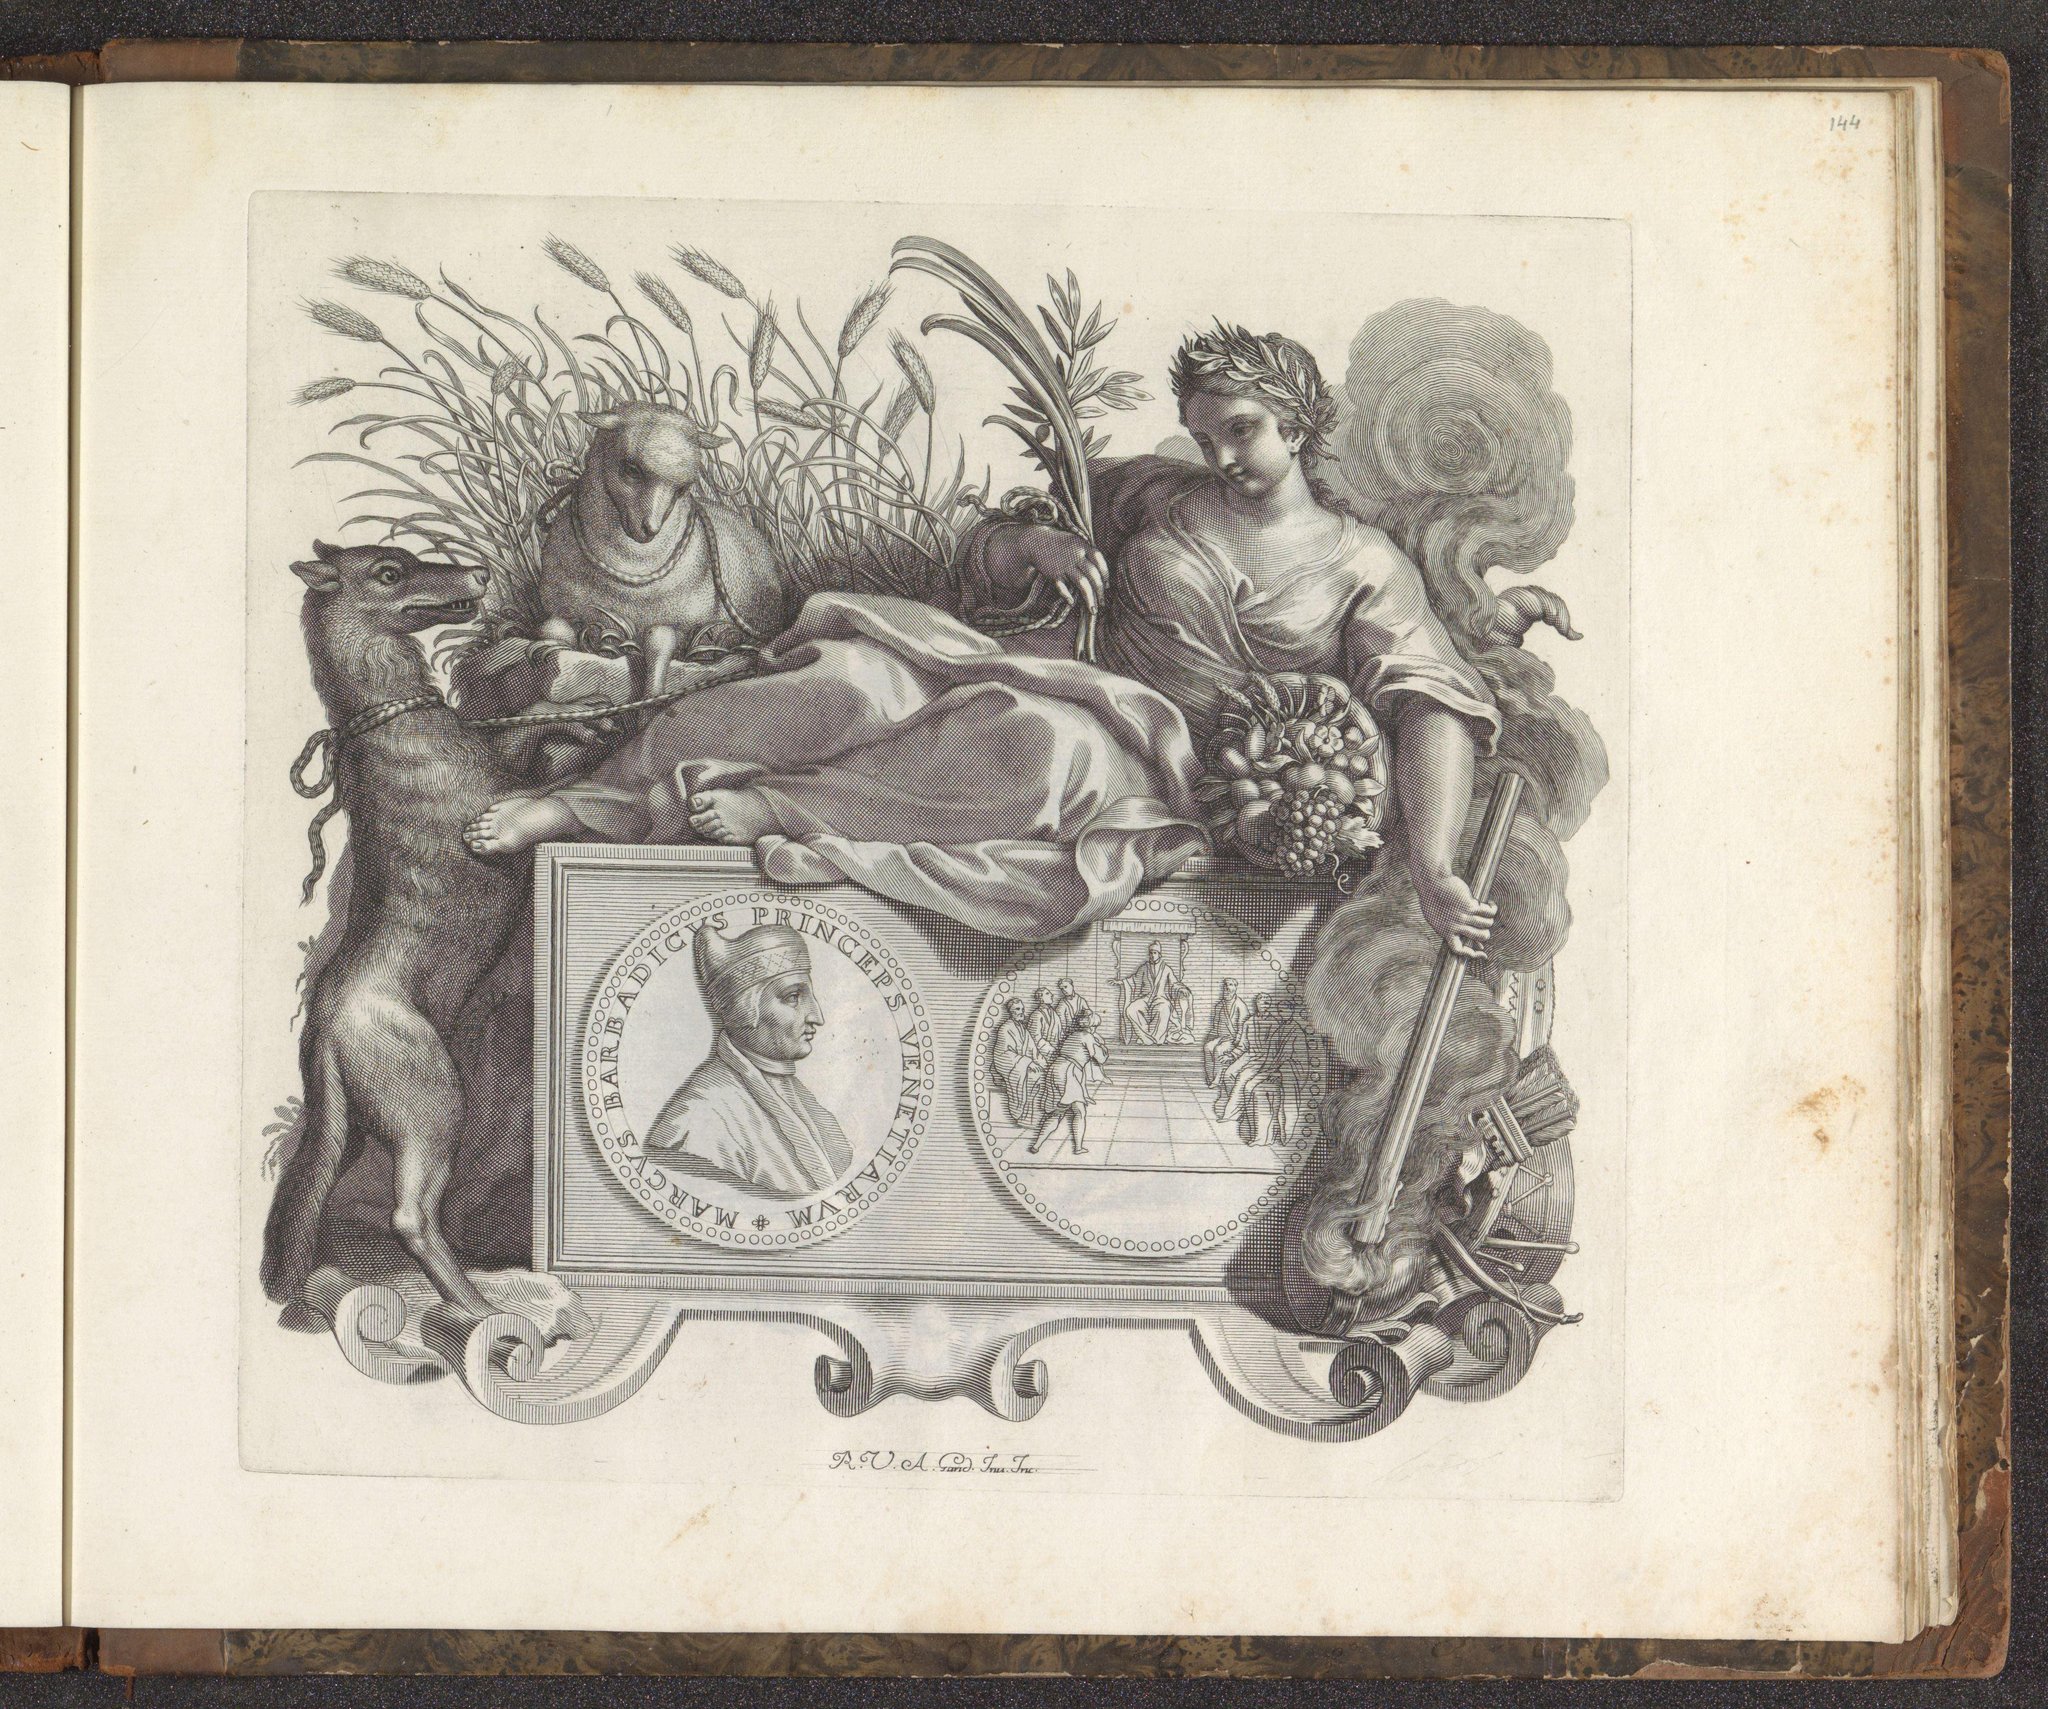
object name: album leaf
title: Portret van Marco Barbarigo en de personificatie van de Vrede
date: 1673-1743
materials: paper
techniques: engraving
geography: rome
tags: torch - bb - torch held upside down, 'cornucopia', horn of plenty, symbols, allegories of peace, 'pax'; 'pace' (ripa), medal (considered as a piece of sculpture, regardless of its specific function), sheep, audition; ruler giving audience, beasts of prey, predatory animals: wolf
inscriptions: collector's mark: Lugt 2228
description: Voetstuk in de vorm van een cartouche. Daarop een medaillon met op de voorzijde het portret van Marco Barbarigo met dogehoed. Op de achterkant ontvangt de doge op zijn troon een Ottomaanse delegatie. Op het voetstuk ligt de personificatie van de Vrede met palmtak en olijftak in de hand en onder haar arm een hoorn des overvloeds. Met een fakkel steekt zij een stapel wapens in brand. Ook houdt zij een wolf en een schaap samengebonden. De prent maakt deel uit van een album.